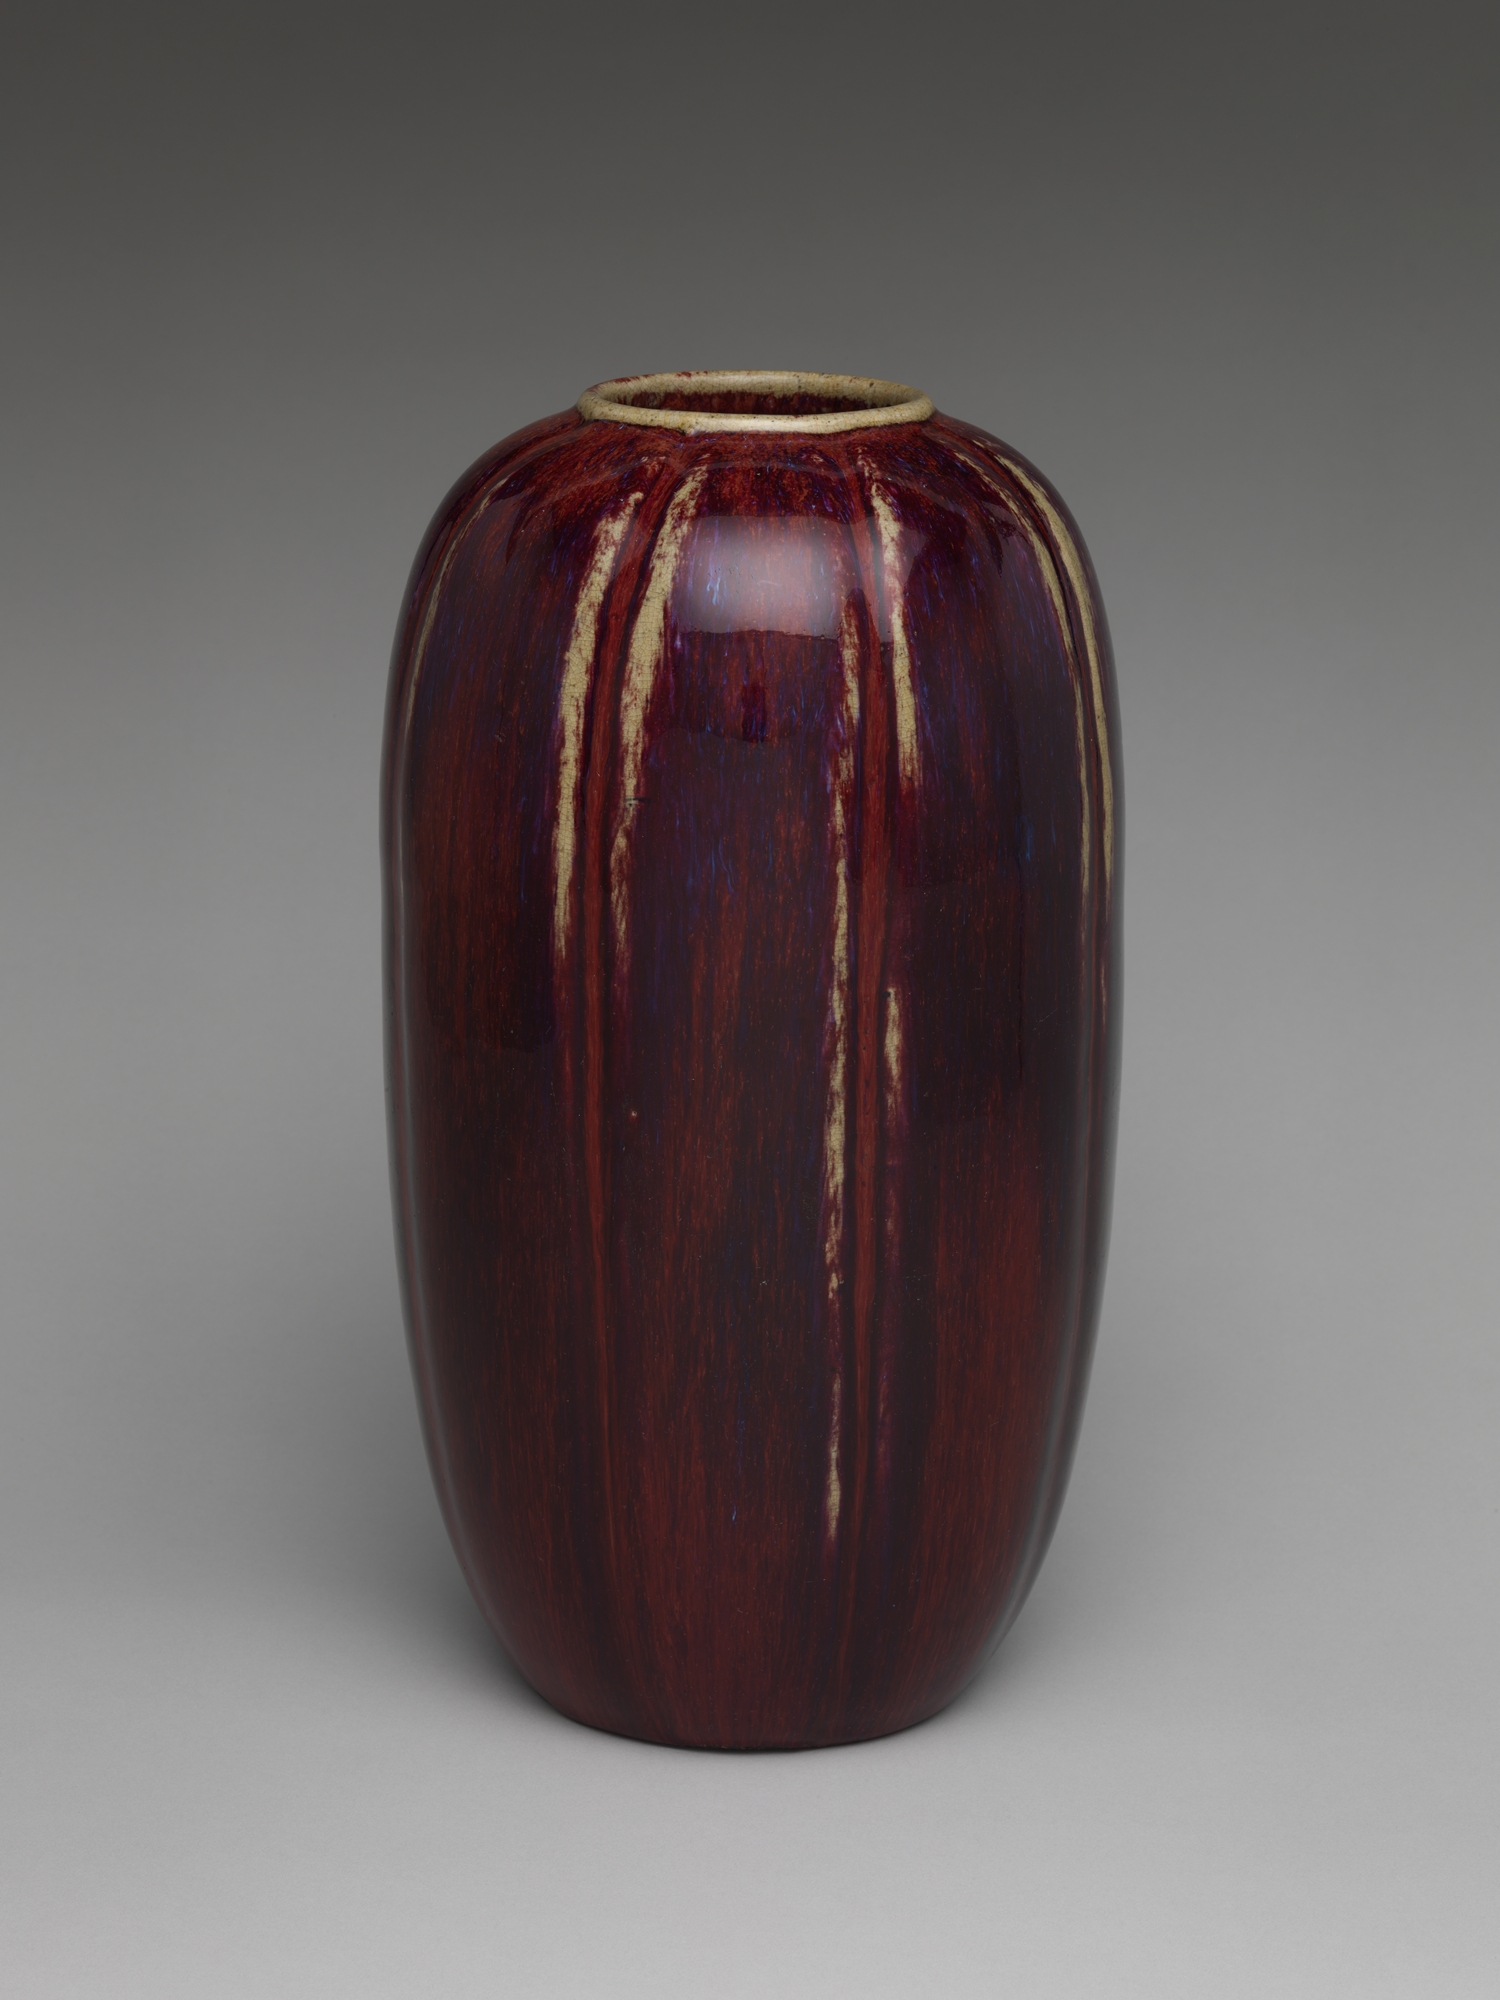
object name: vase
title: Vase in shape of winter melon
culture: chinese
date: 1801-1833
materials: glaze, porcelain